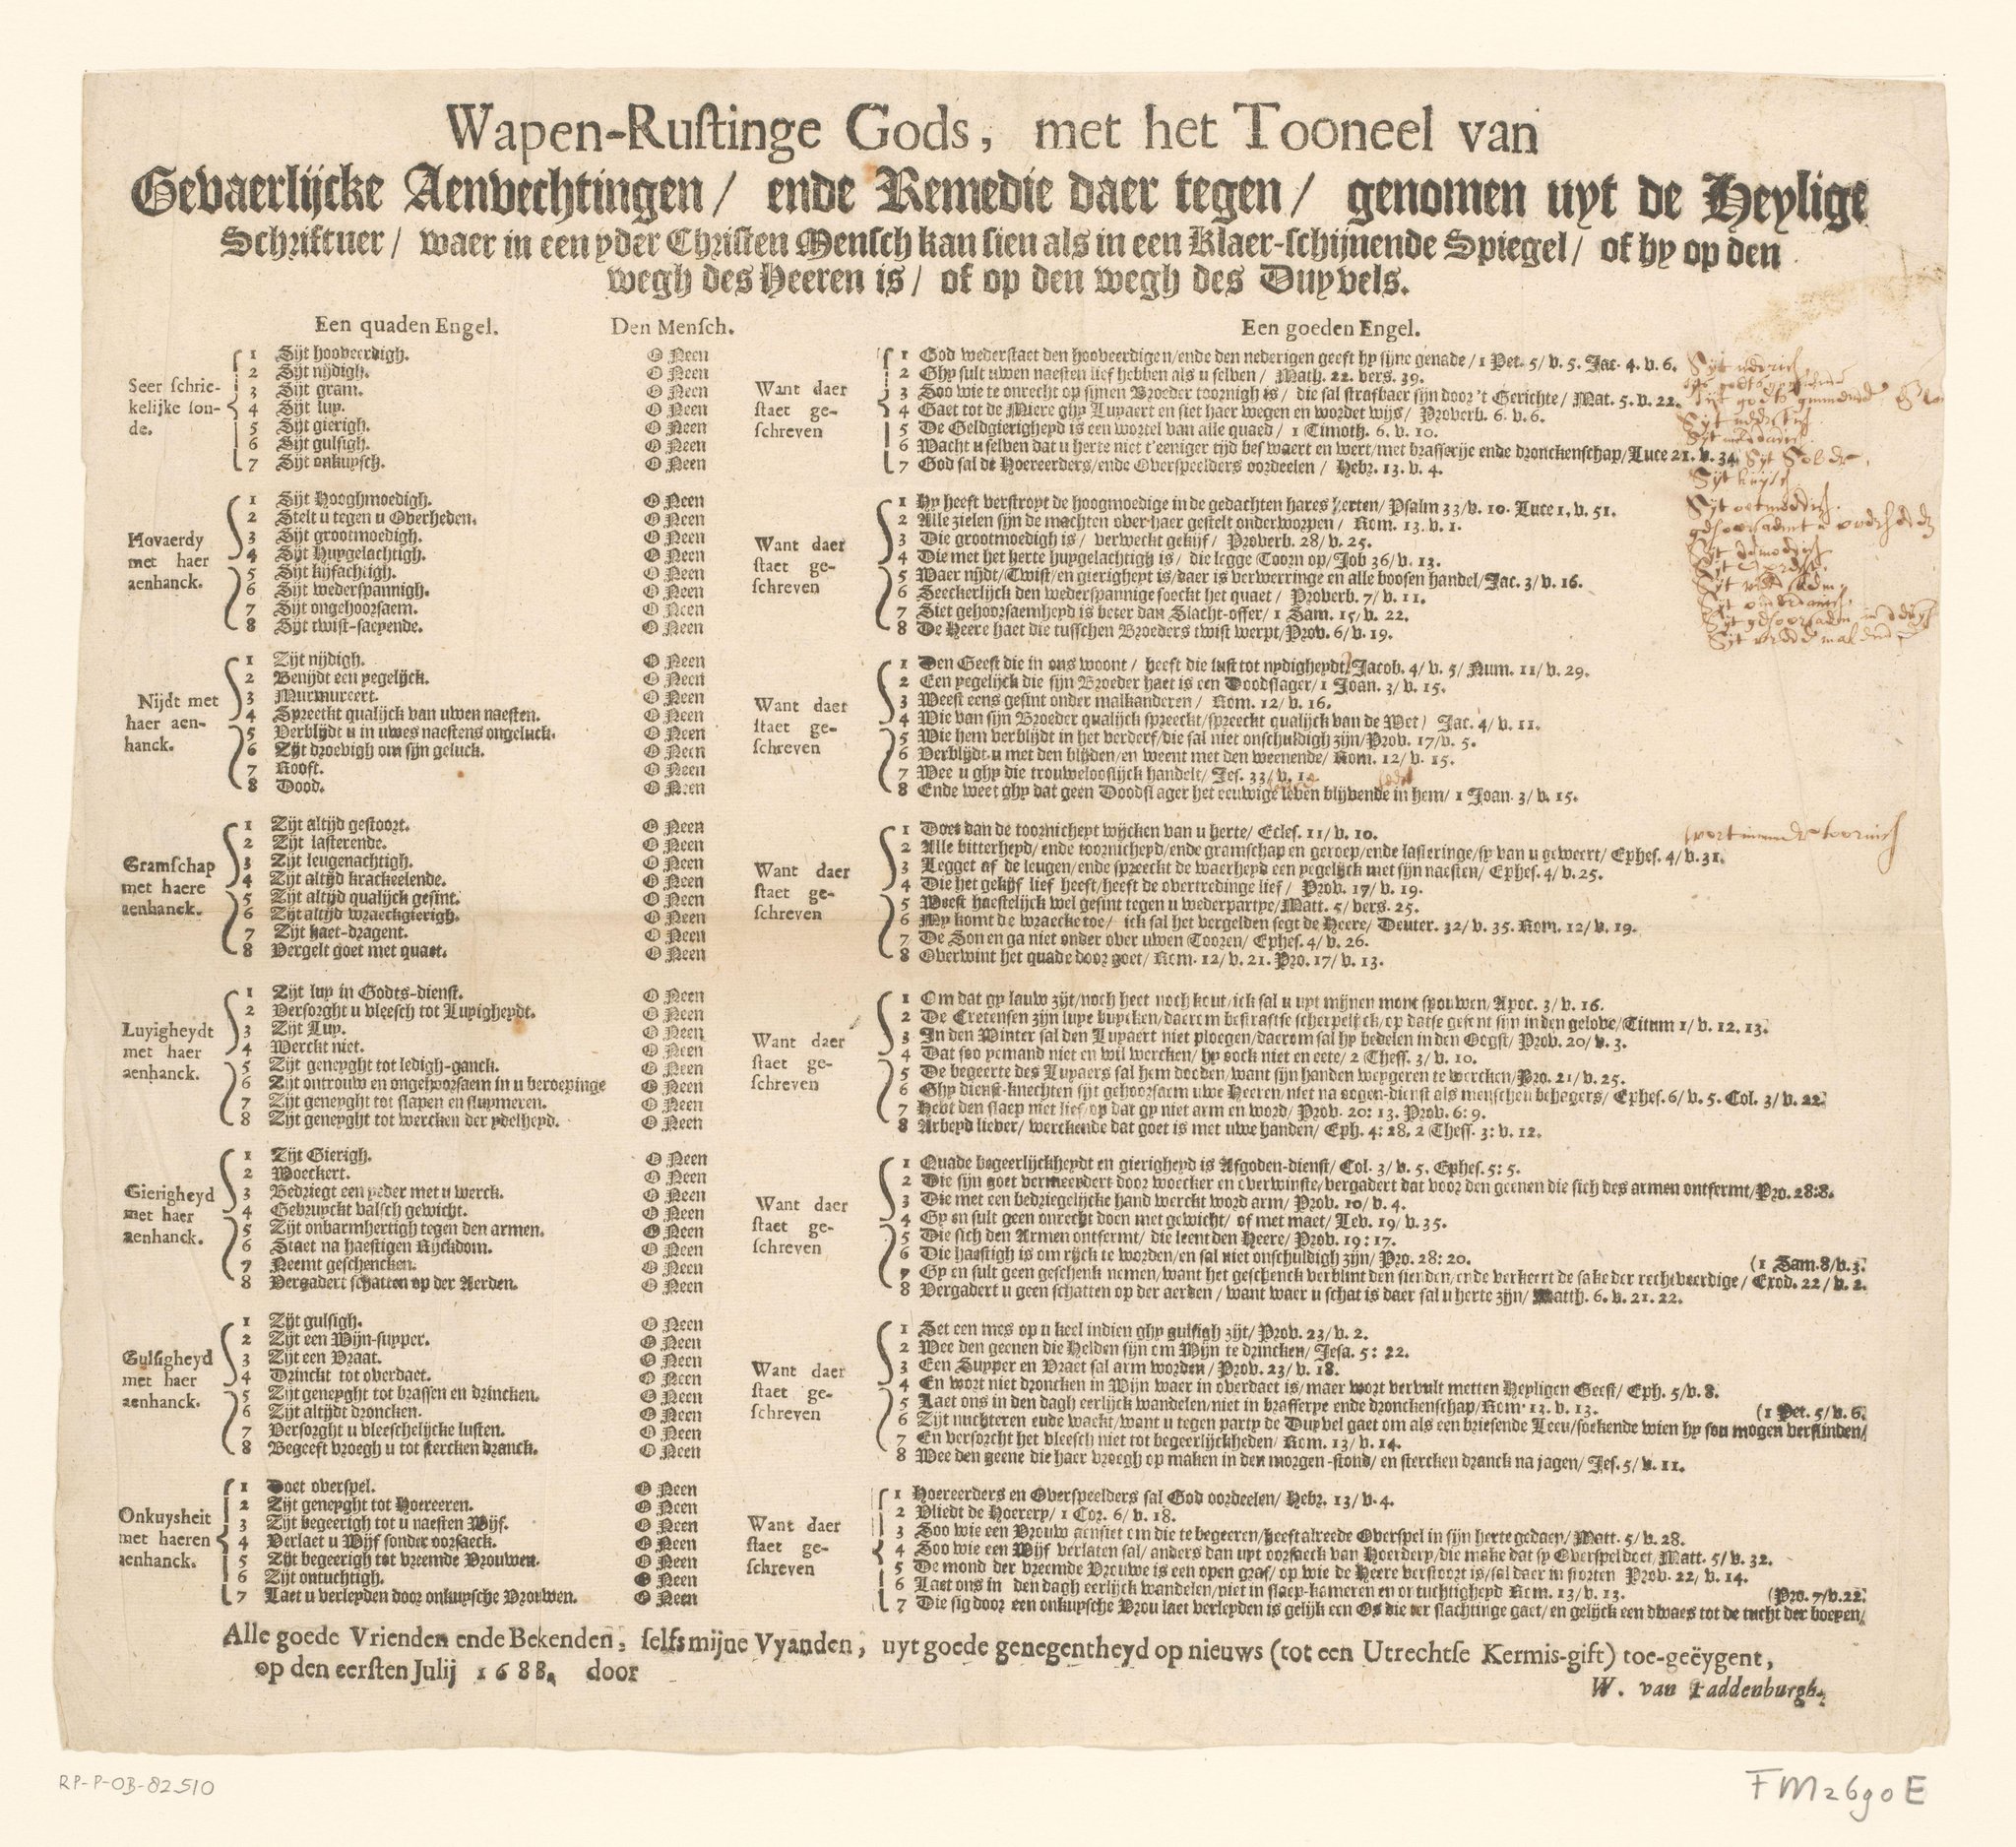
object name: text sheet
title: Wapenrusting Gods, 1688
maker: w. van paddenburgh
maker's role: publisher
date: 1687-1689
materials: paper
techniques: letterpress printing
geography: utrecht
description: De Wapenrusting Gods. Tekstblad met een lijst van gevaarlijke aanvechtingen gebaseerd op de zeven hoofdzonden en remedies hiertegen in bijbelteksten. Uitgegeven als een kermisgift.